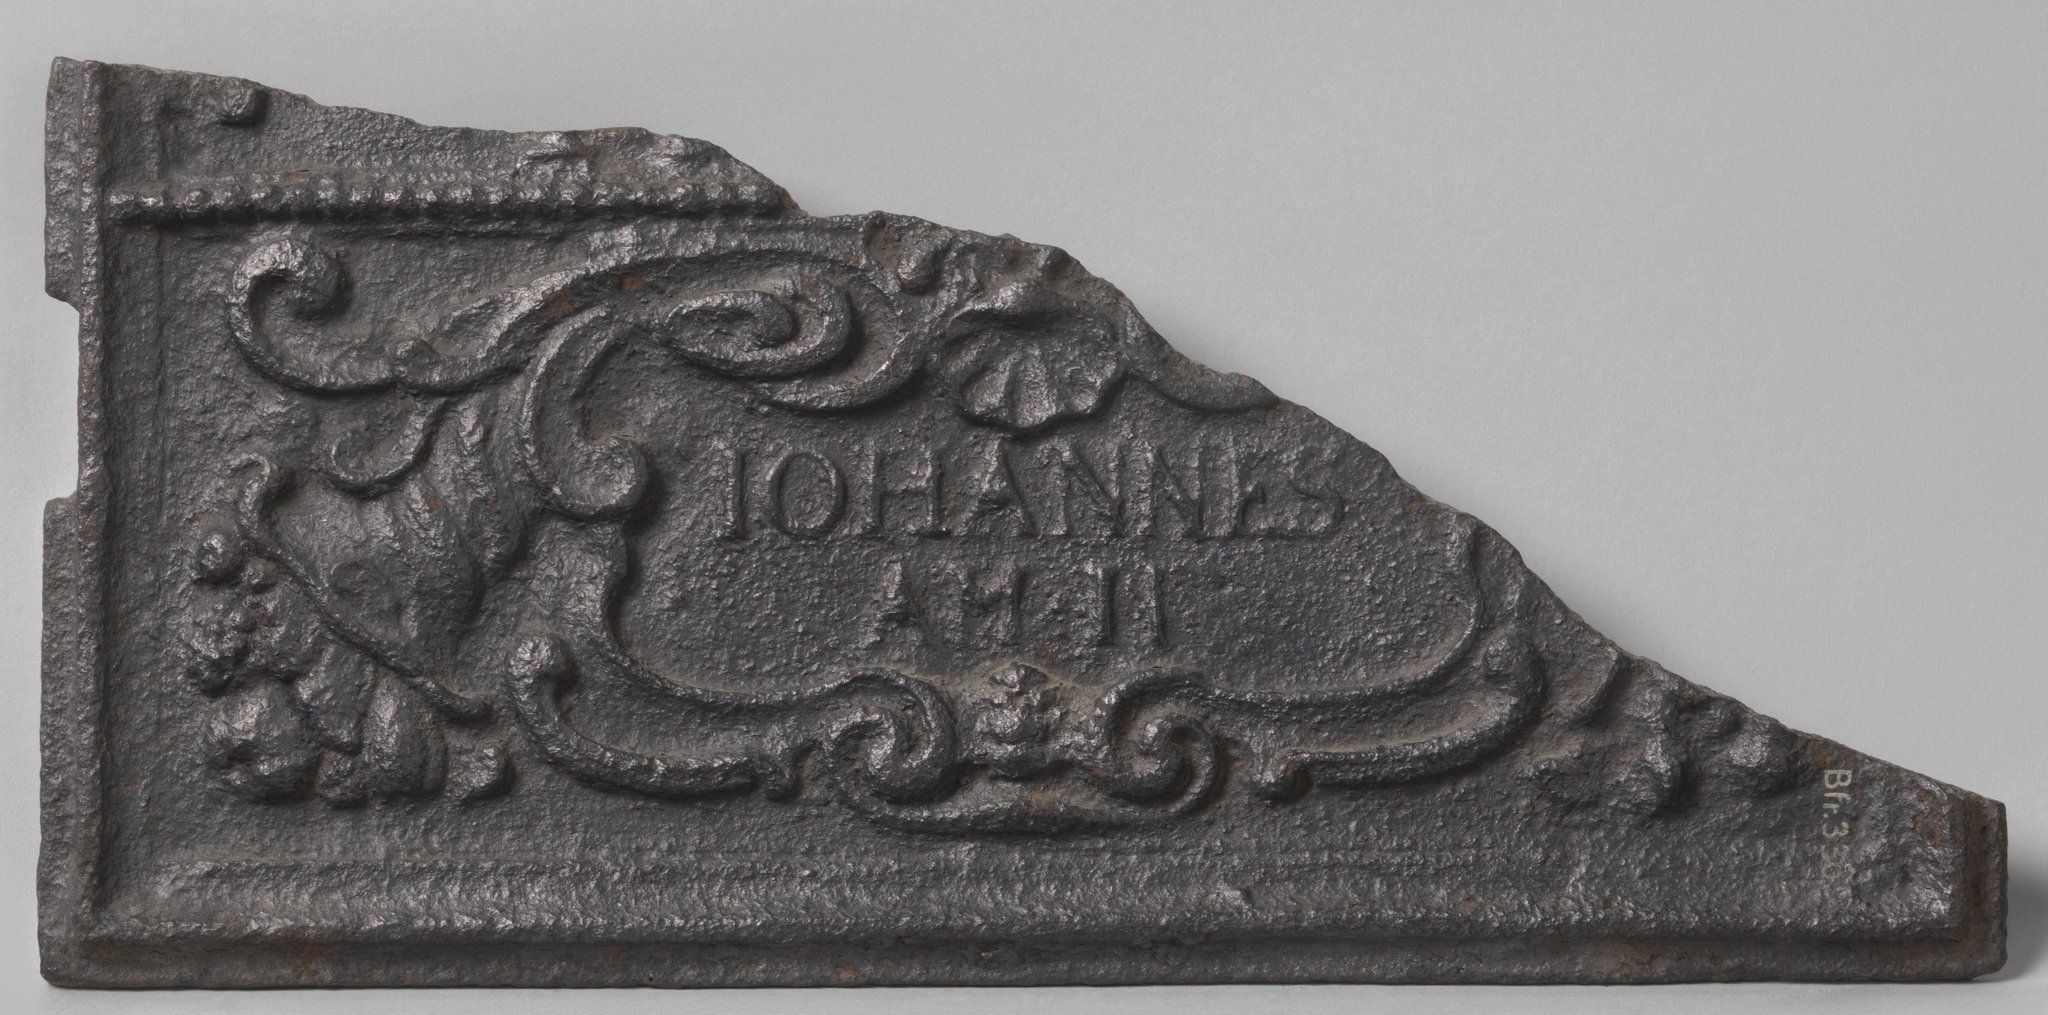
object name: stove plate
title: Kachelplaat met voorstelling van de bruiloft te Kana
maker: Anonymous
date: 1550-1650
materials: iron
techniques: casting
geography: eifel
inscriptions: inscription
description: Gietijzeren kachelplaat, verdeeld in twee zones. In de onderste zone is een cartoucehe van bladmotieven met daarin het opschrift: JOHANNES AM II. De bovenste zone is een los deel, genummerd BK-BFR-320.